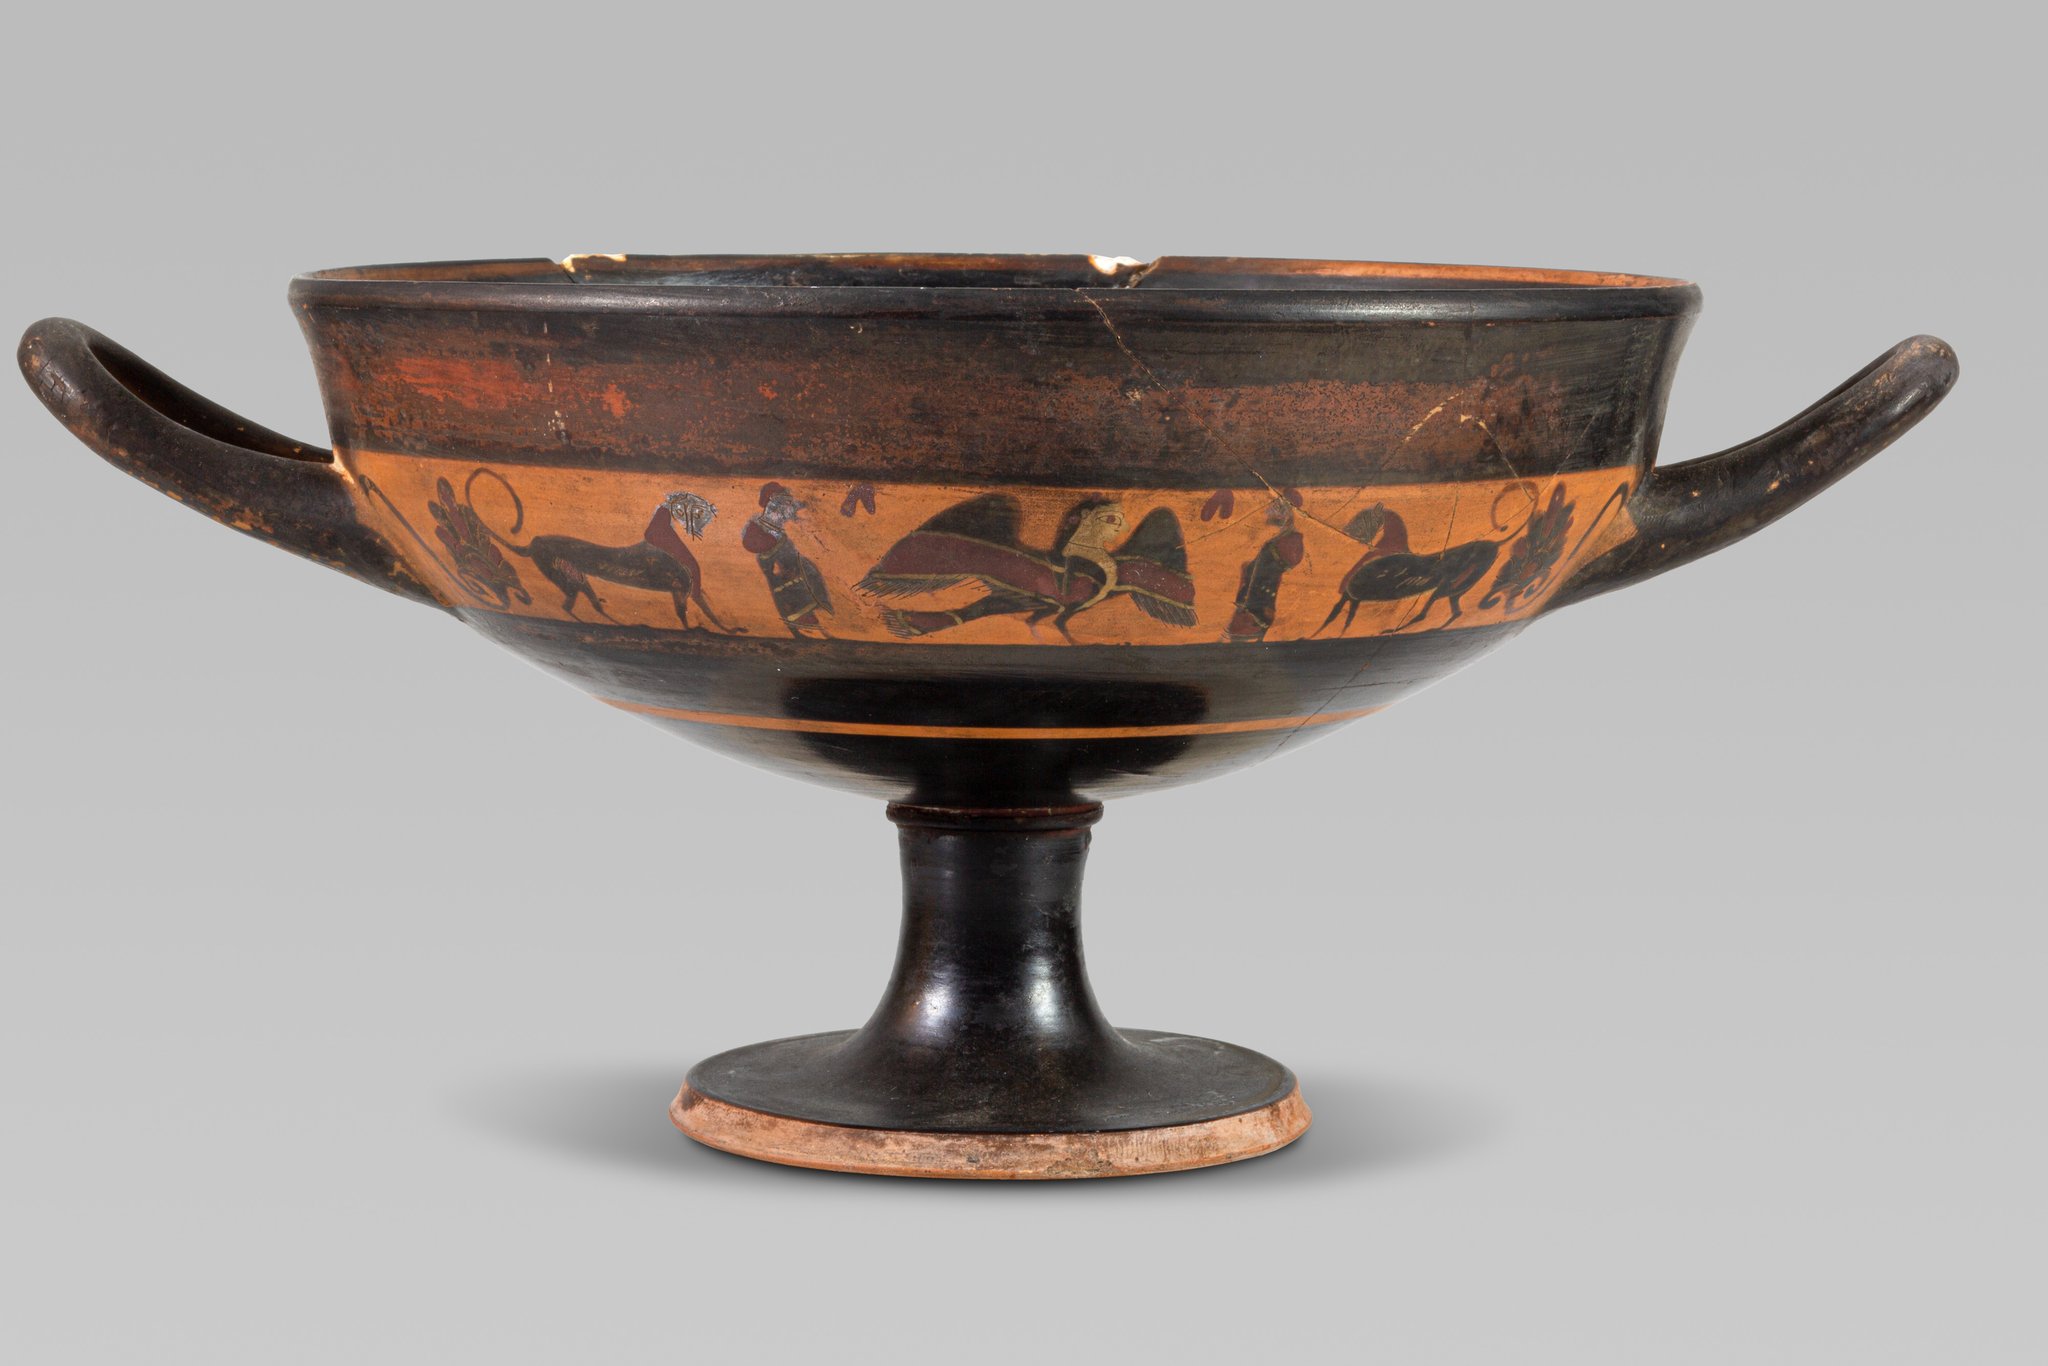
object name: kylix, band cup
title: Kylix, band-cup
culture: greek, attic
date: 540 BCE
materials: terracotta